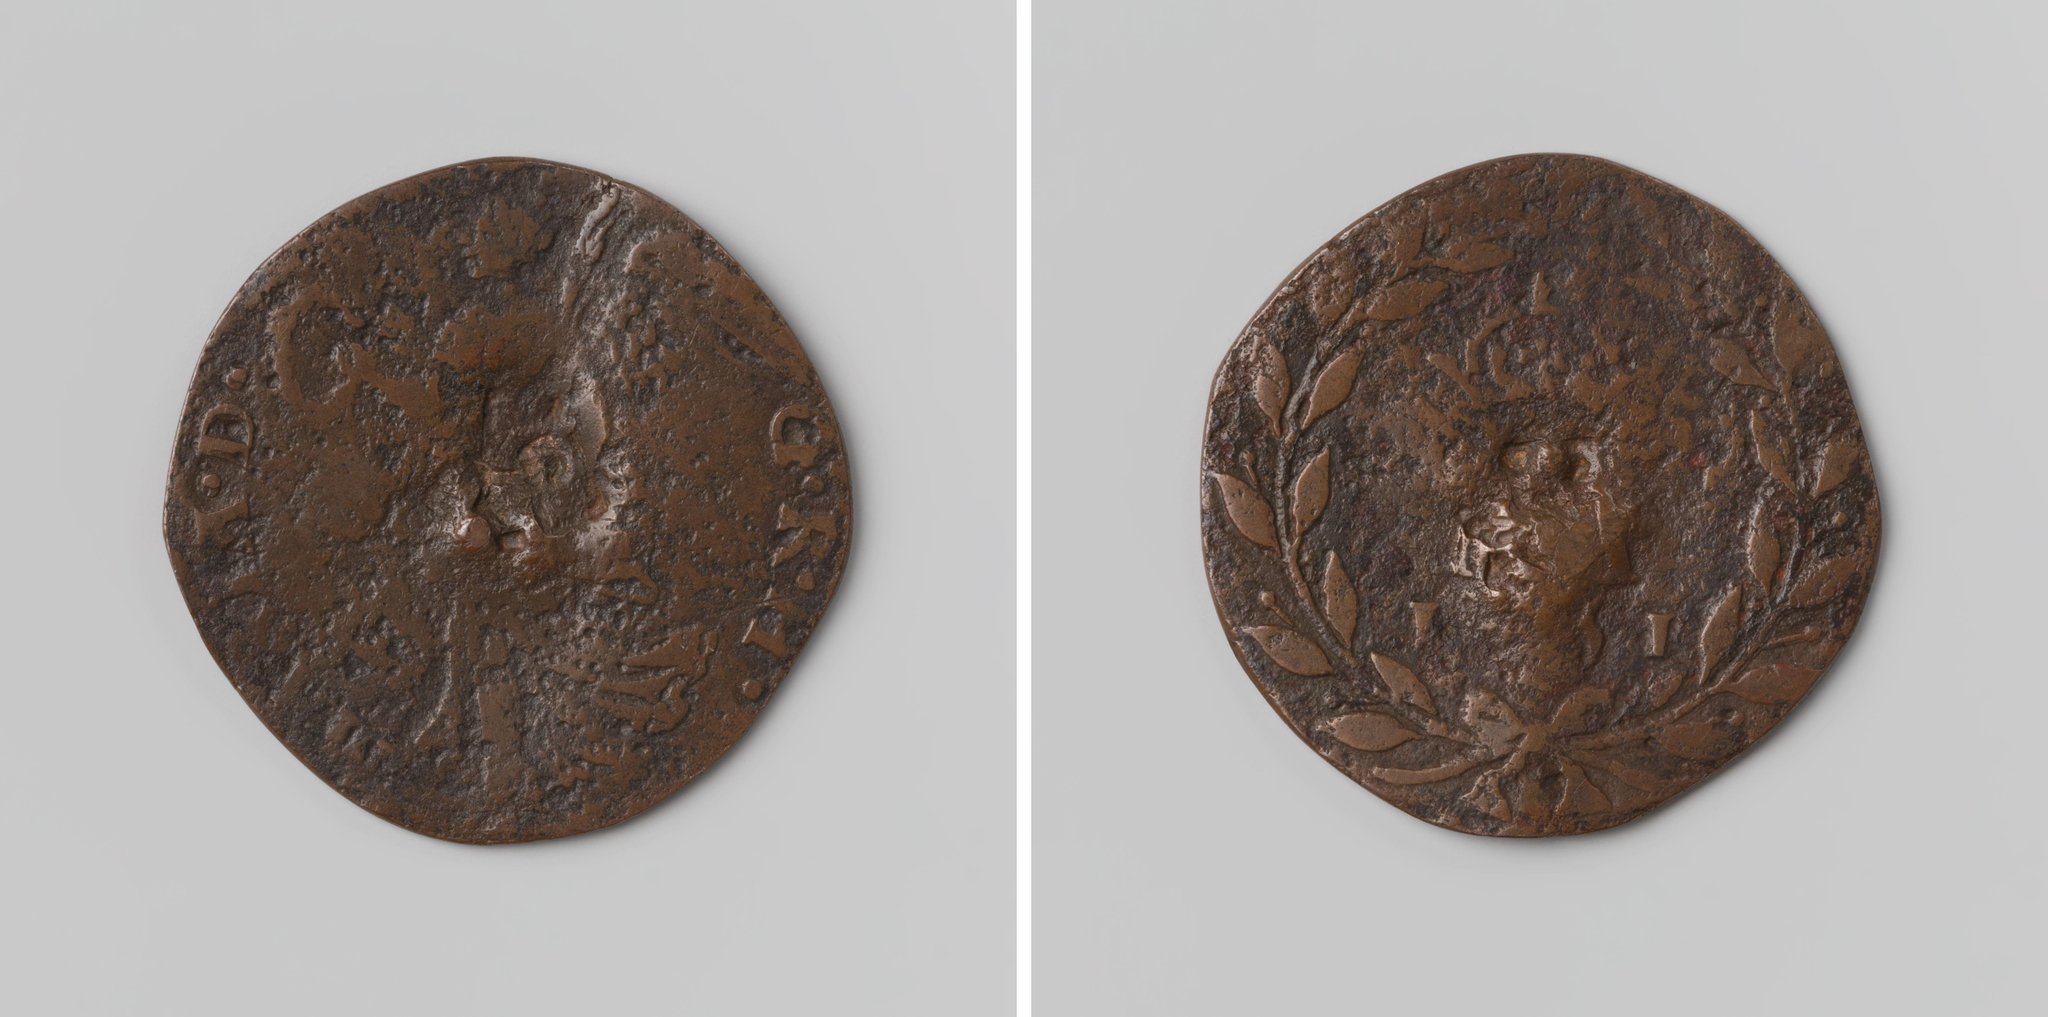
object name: jeton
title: Maria van Hongarije, landvoogdes der Nederlanden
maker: Anonymous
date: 1551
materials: copper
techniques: striking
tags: brussels, maria van hongarije (landvoogdes der nederlanden)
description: Koperen penning. Voorzijde: gevleugelde Overwinning met lauwerkrans in rechter- en palmtak in linkerhand binnen omschrift. Keerzijde: letter M onder kroon, boven jaartal binnen lauwerkrans